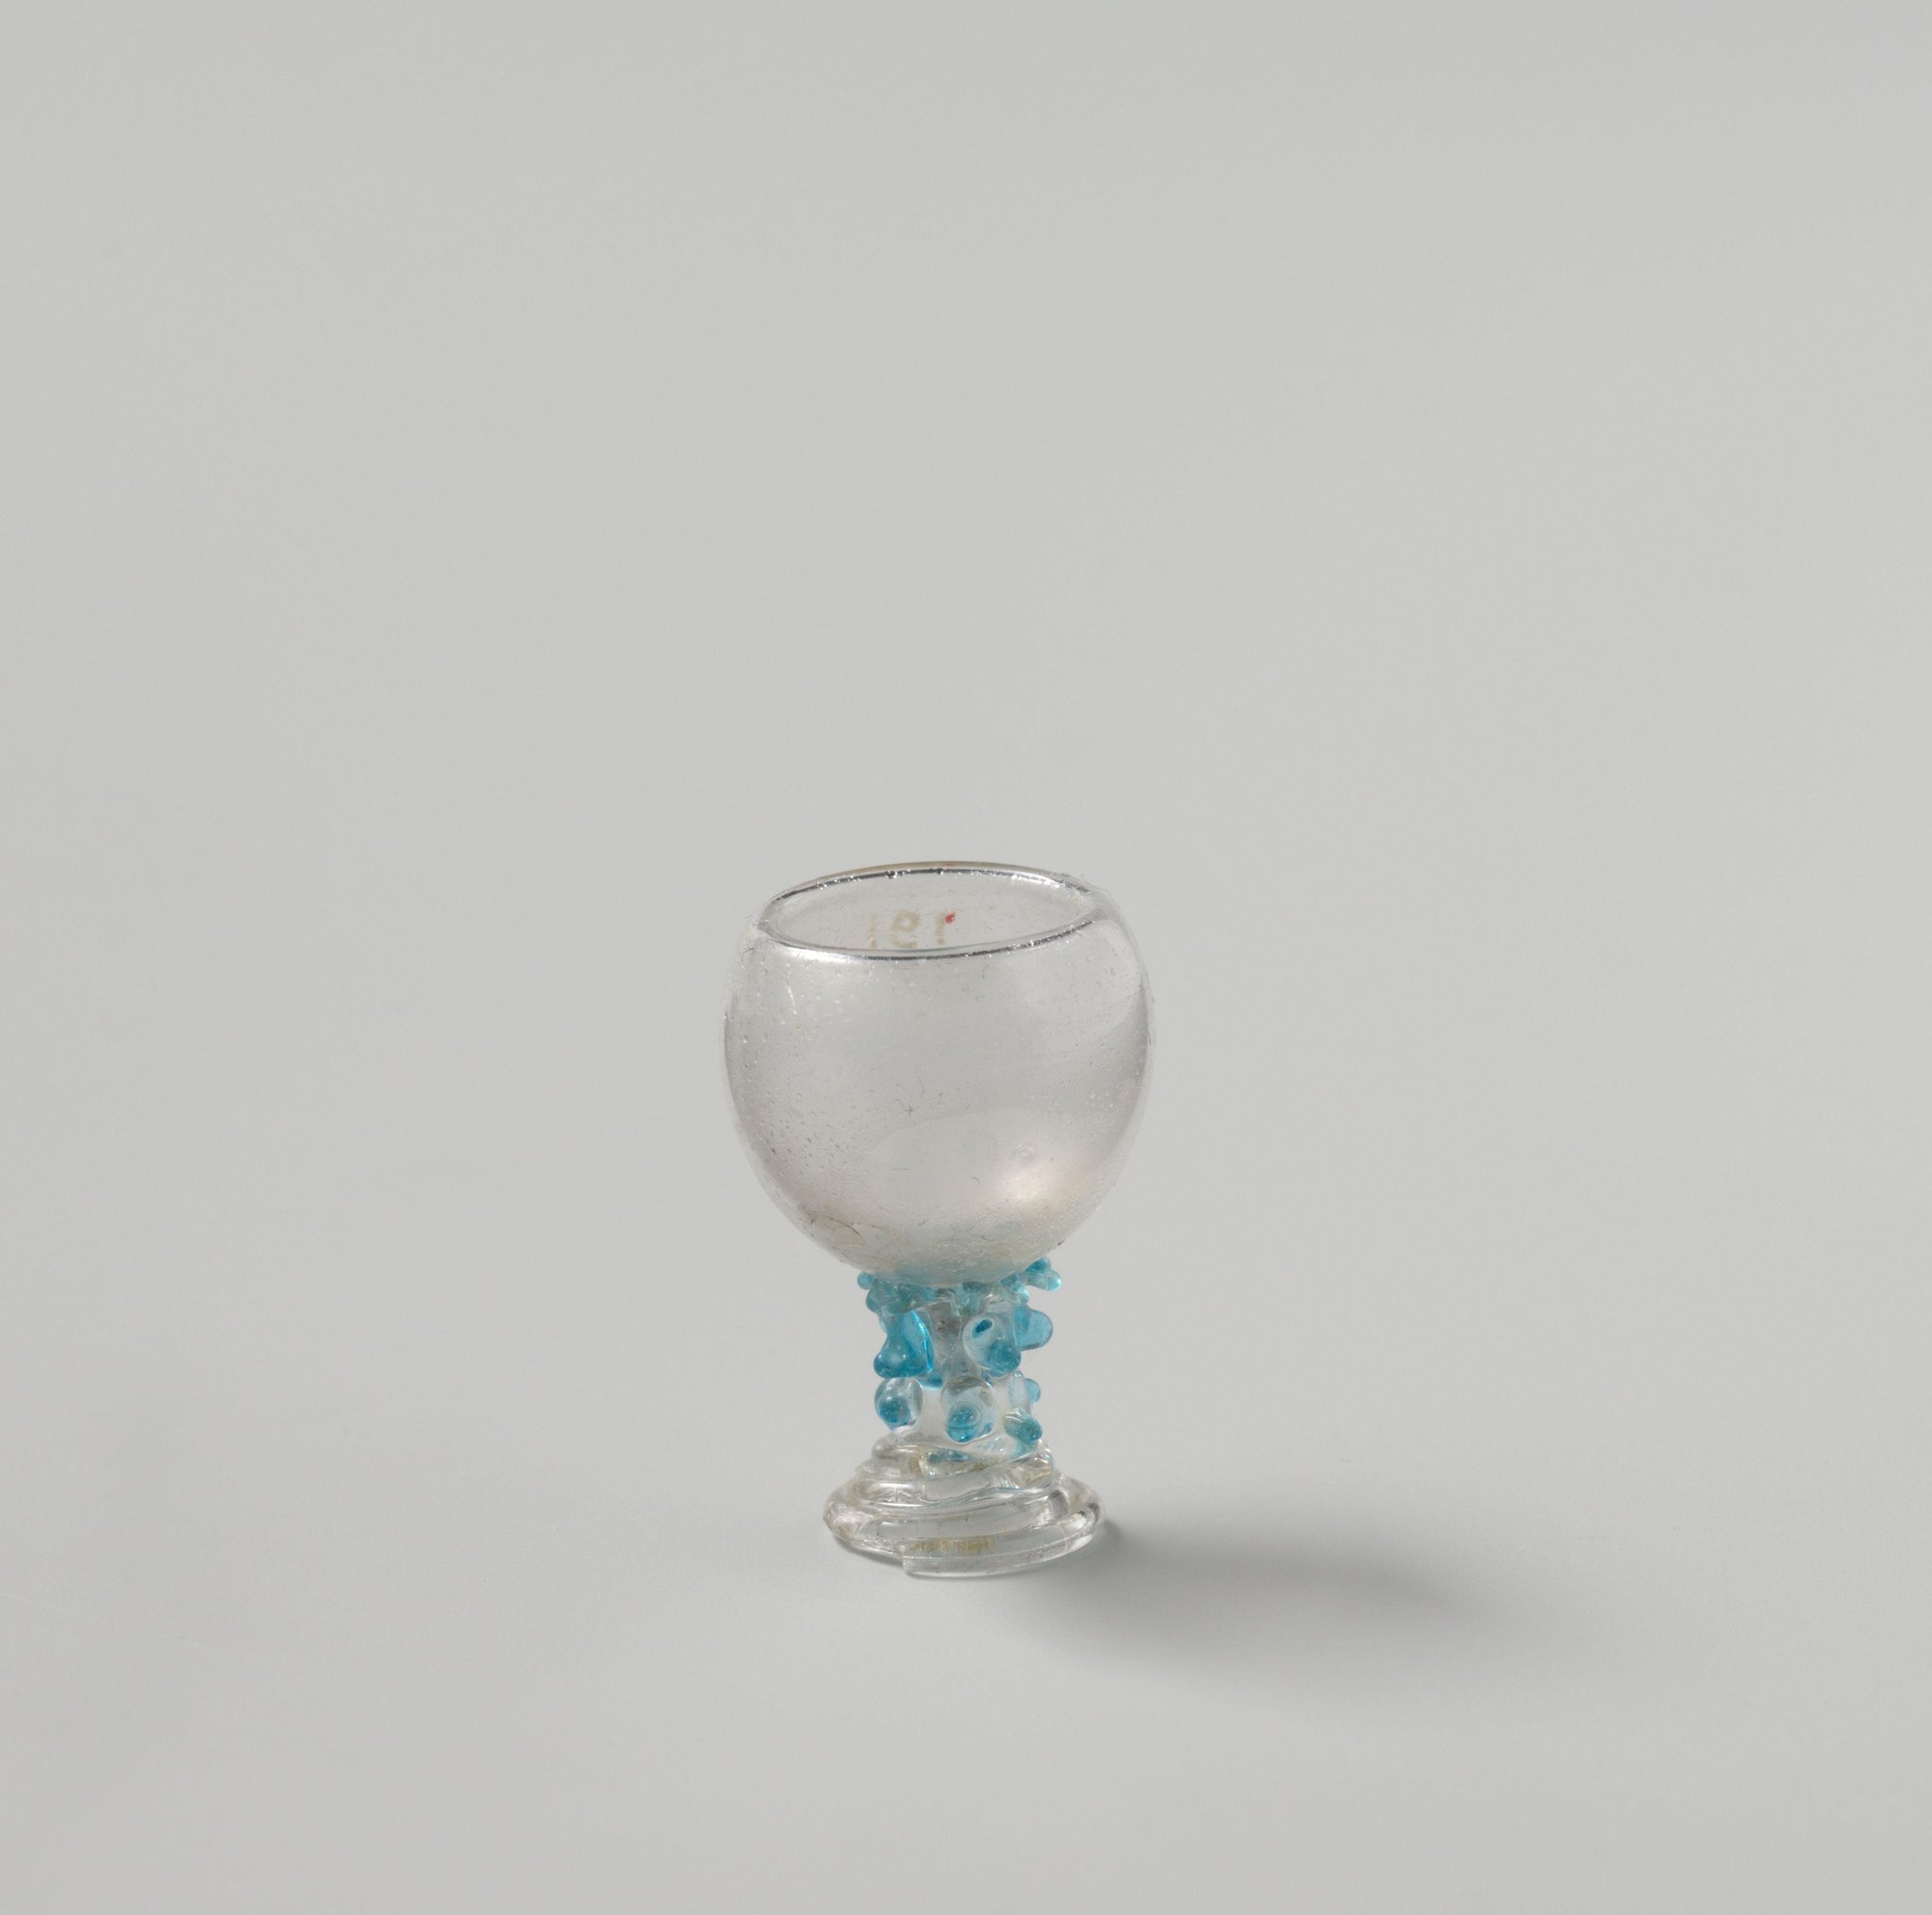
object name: miniature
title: Roemer van helder kleurloos glas met blauwe noppen op de schacht; cuppa dubbelwandig; voet van gespannen glasdraad.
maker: Anonymous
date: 1675-1710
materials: glass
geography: amsterdam